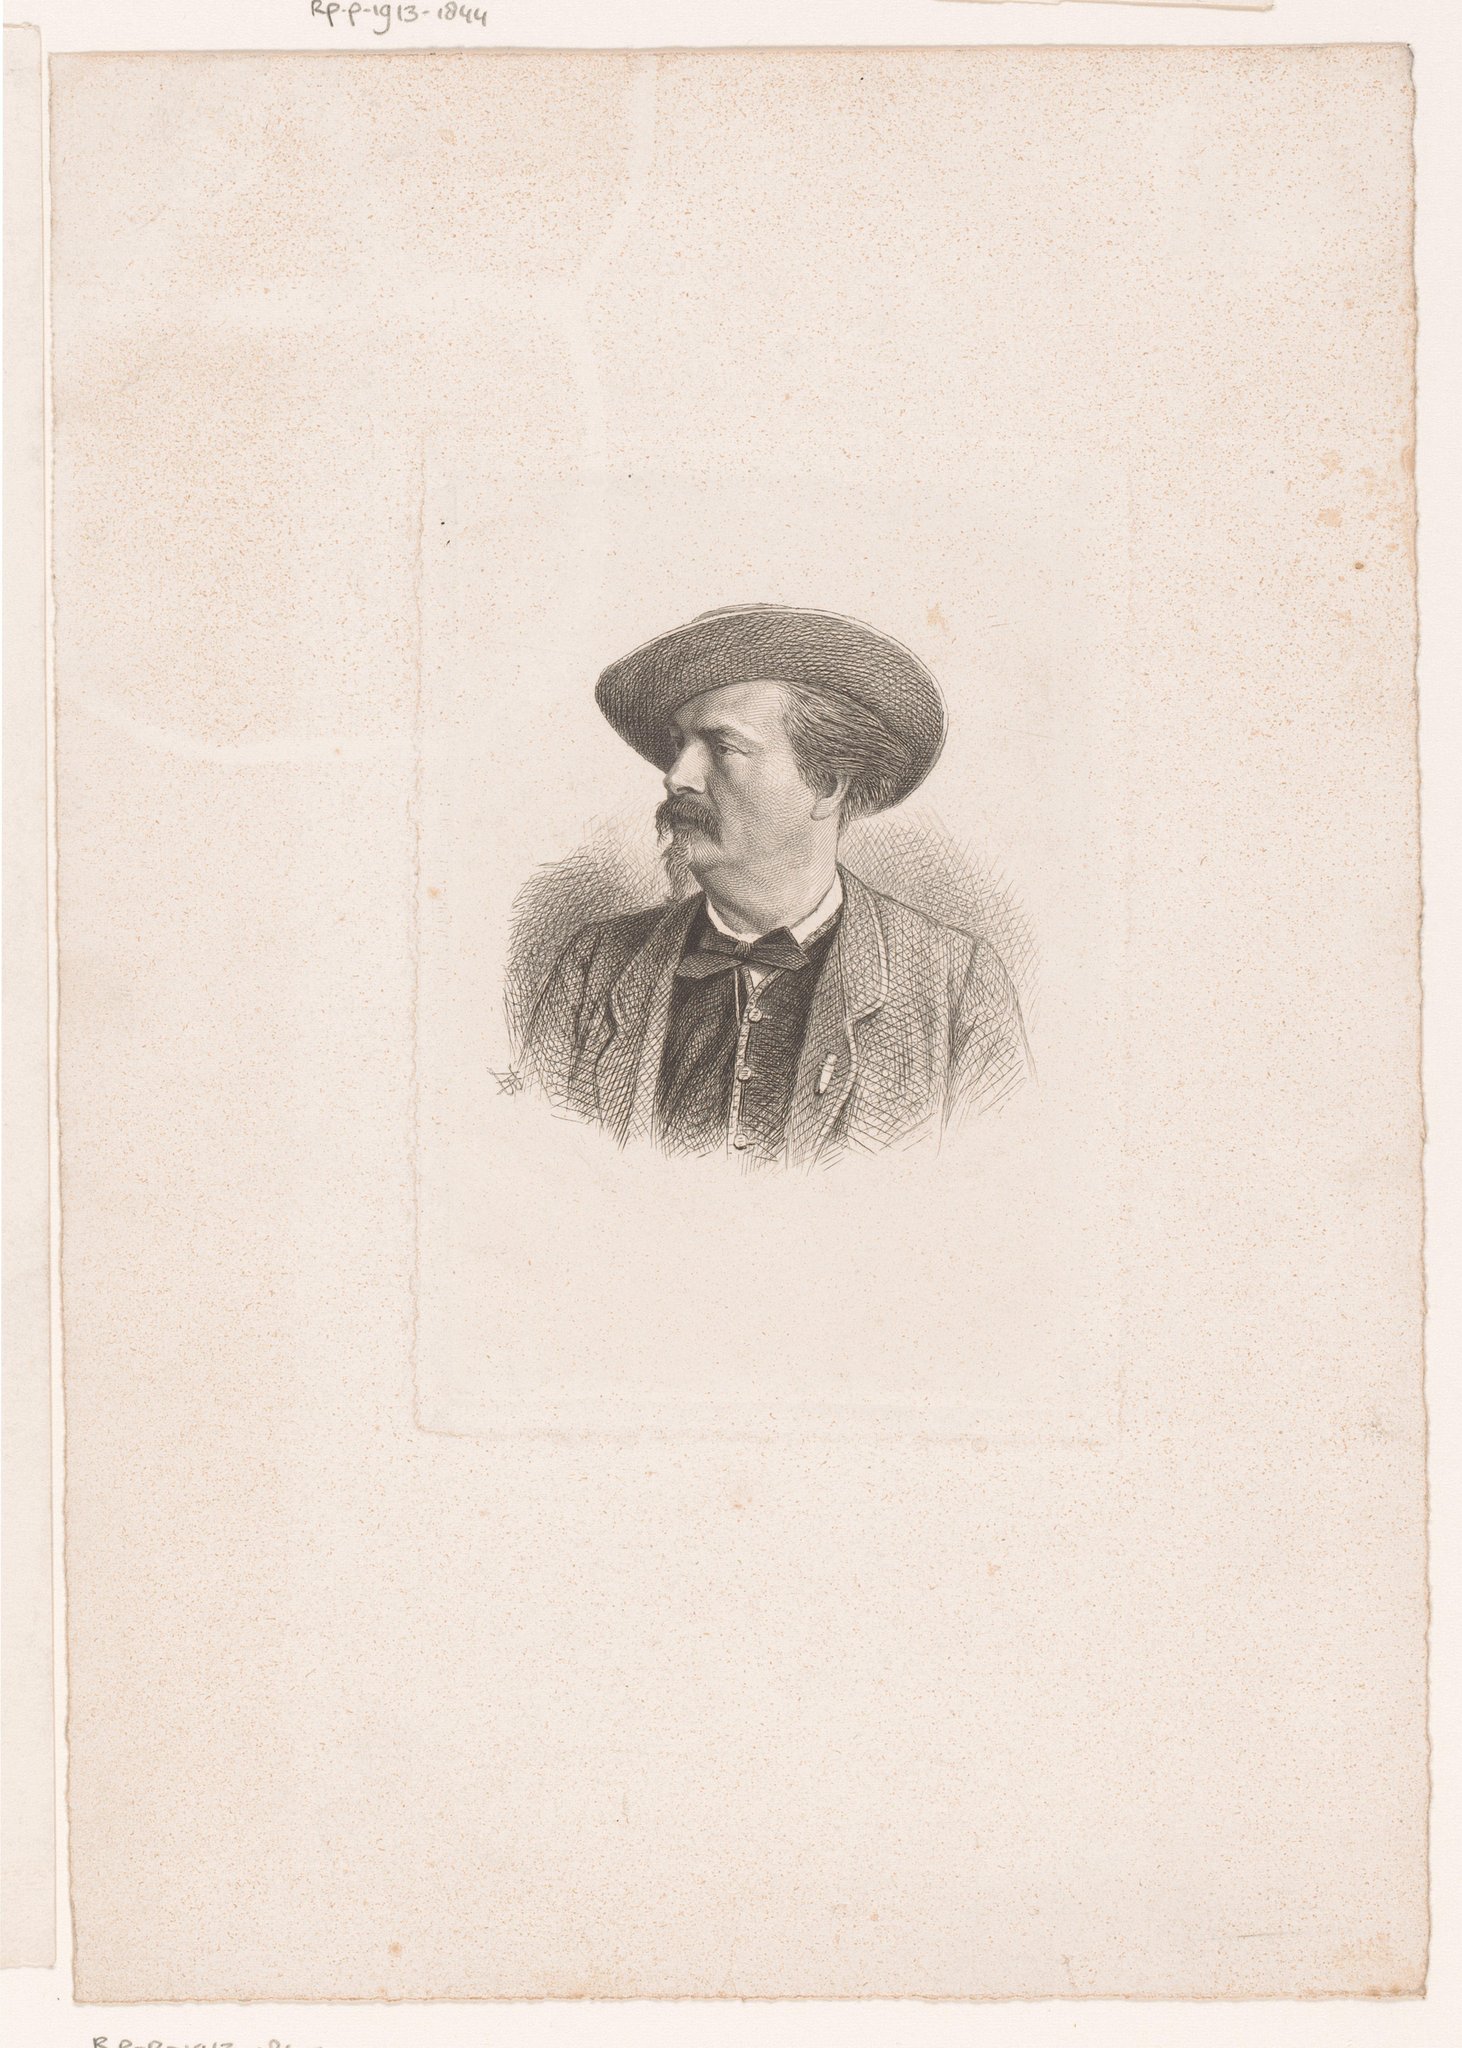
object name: print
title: Portret van een onbekende man met hoed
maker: jean baptiste pierre michiels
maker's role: print maker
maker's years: 1821-1890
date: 1831-1890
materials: paper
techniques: etching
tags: head-gear, adult man, historical persons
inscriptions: collector's mark: Lugt 2228